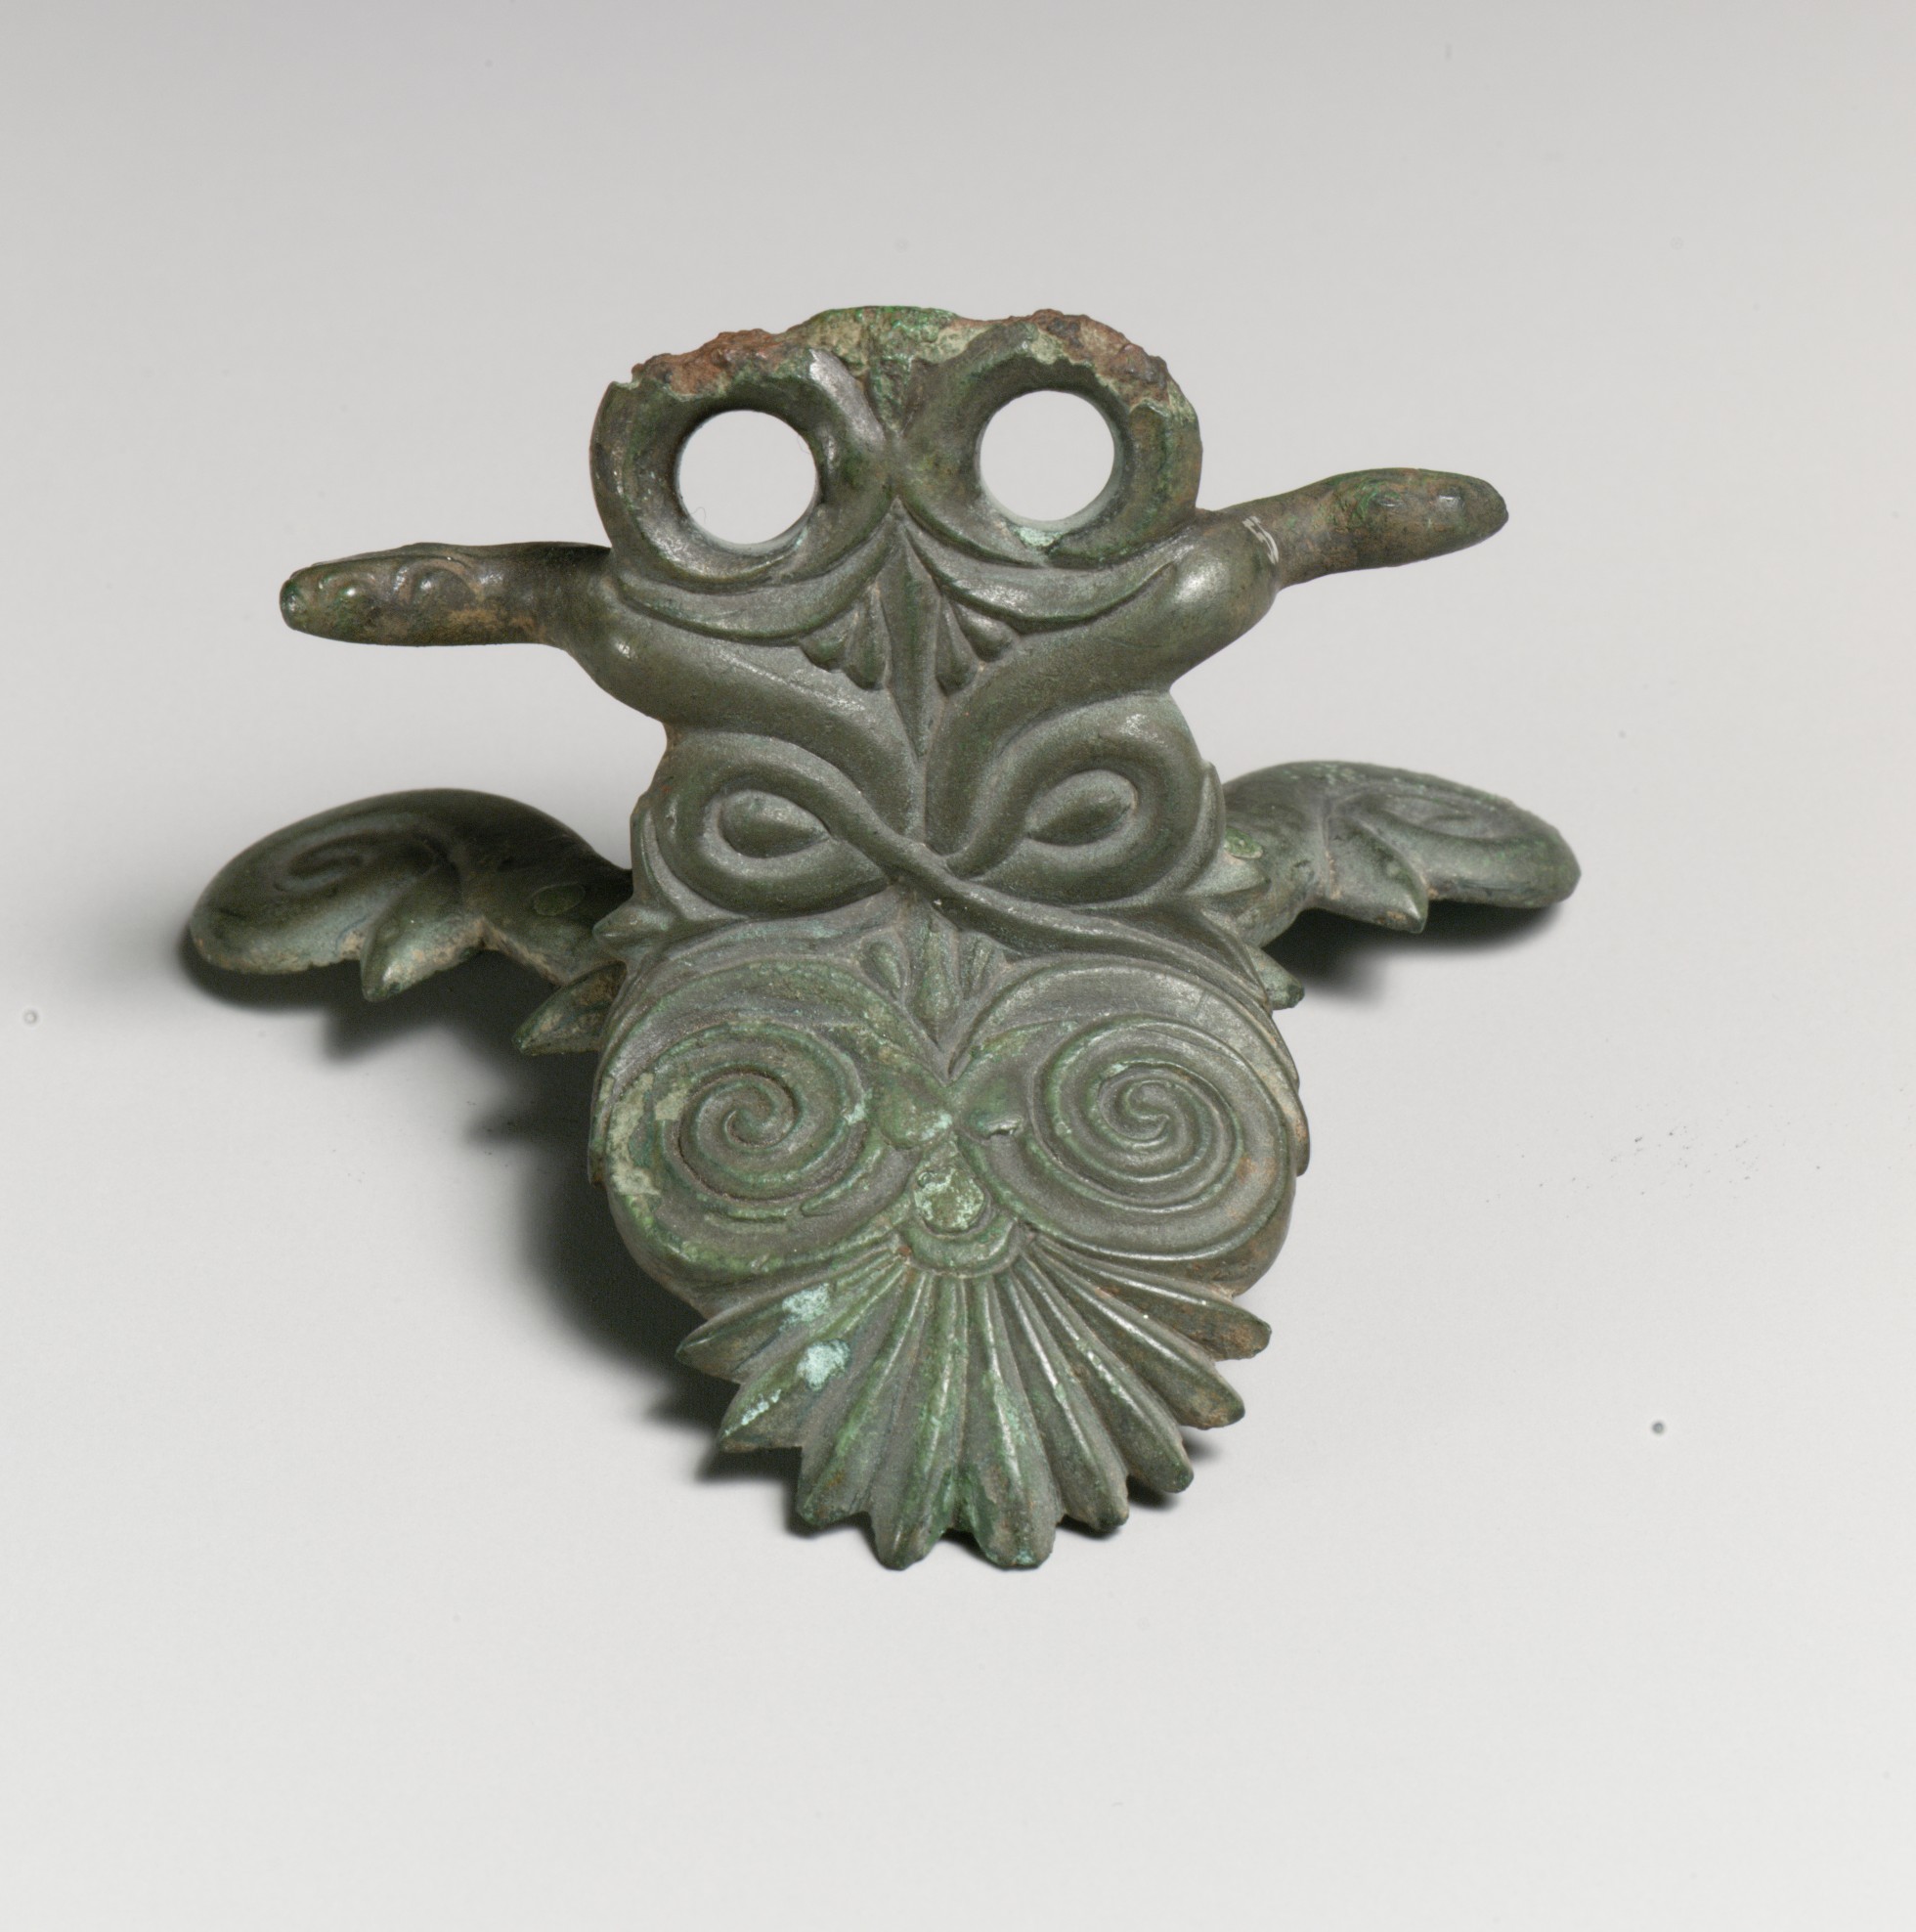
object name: handle of a situla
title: Pair of bronze situla (bucket) handles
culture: etruscan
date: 600-501 BCE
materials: bronze